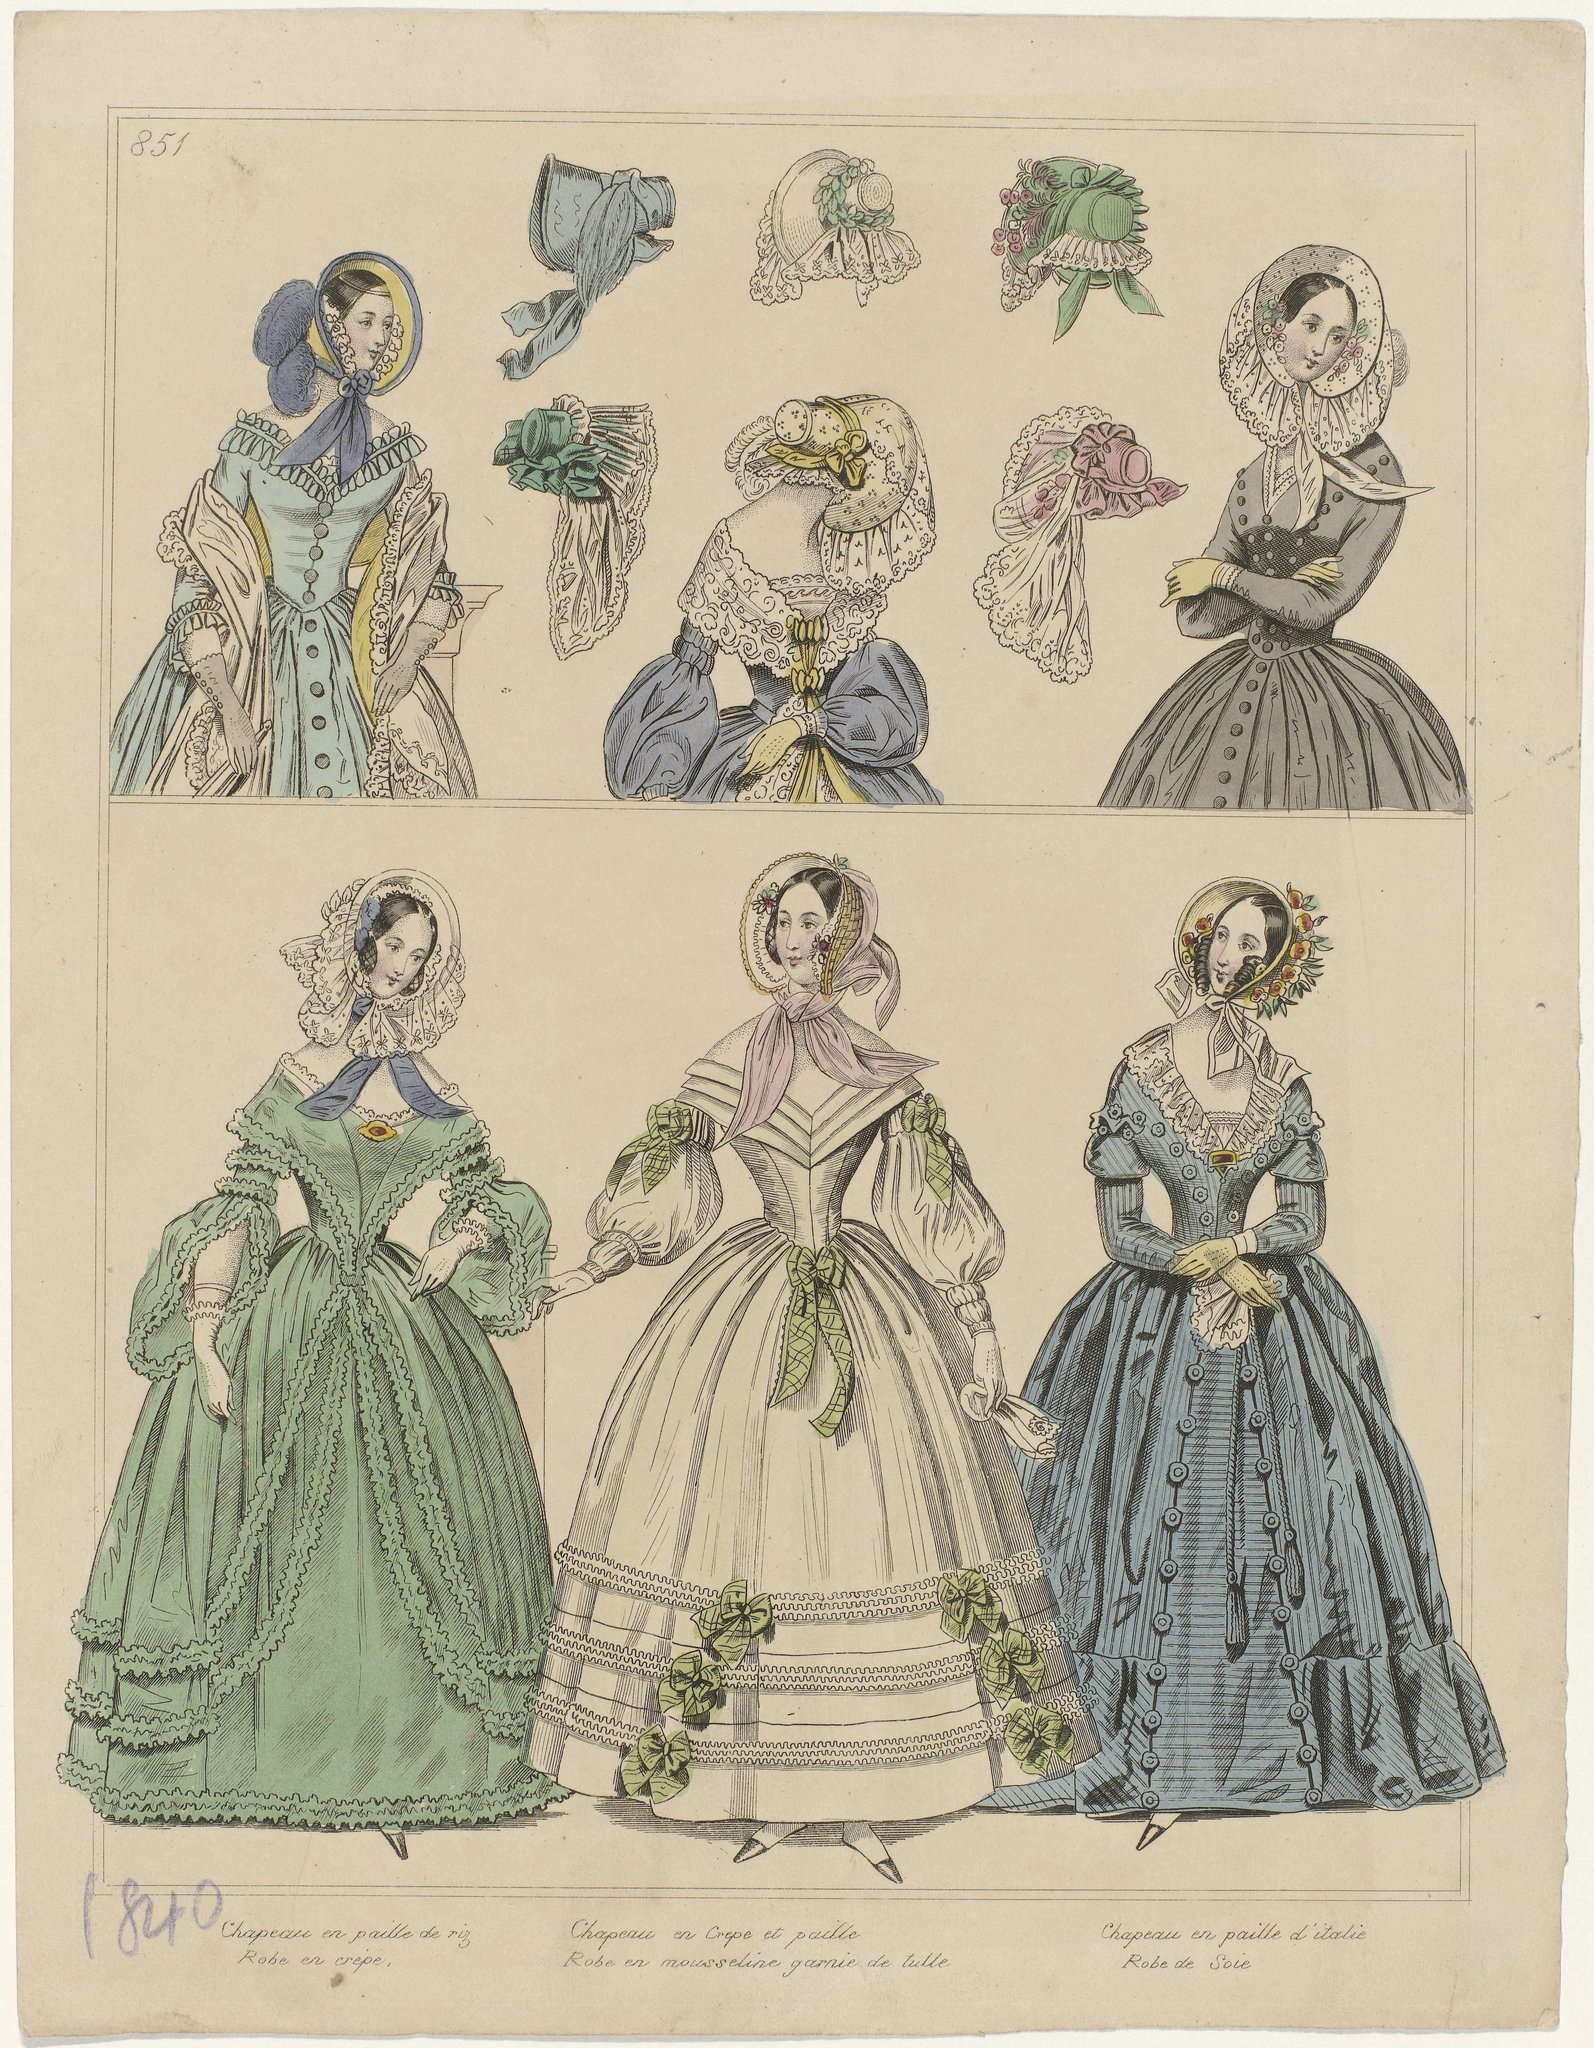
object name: fashion print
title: Townsend's Monthly Selection of Parisian Costumes, 1840, No. 851 : Chapeaux en paille de riz (...)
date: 1840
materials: paper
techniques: engraving, hand coloring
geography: london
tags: bow (ornamental part of clothing) (+ women's clothes), border, ribbon, braid (+ textile fabrics used for clothes), fashion plates, head-gear: hat (+ women's clothes), dress, gown (+ women's clothes), head-gear: hat (+ other materials used for clothes)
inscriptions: caption: ‘Chapeau en paille de riz. Robe en crêpe. / Chapeau en Crêpe et paille. Robe en mousseline garnie de tulle. / Chapeau en paille d'italie. Robe de Soie.’